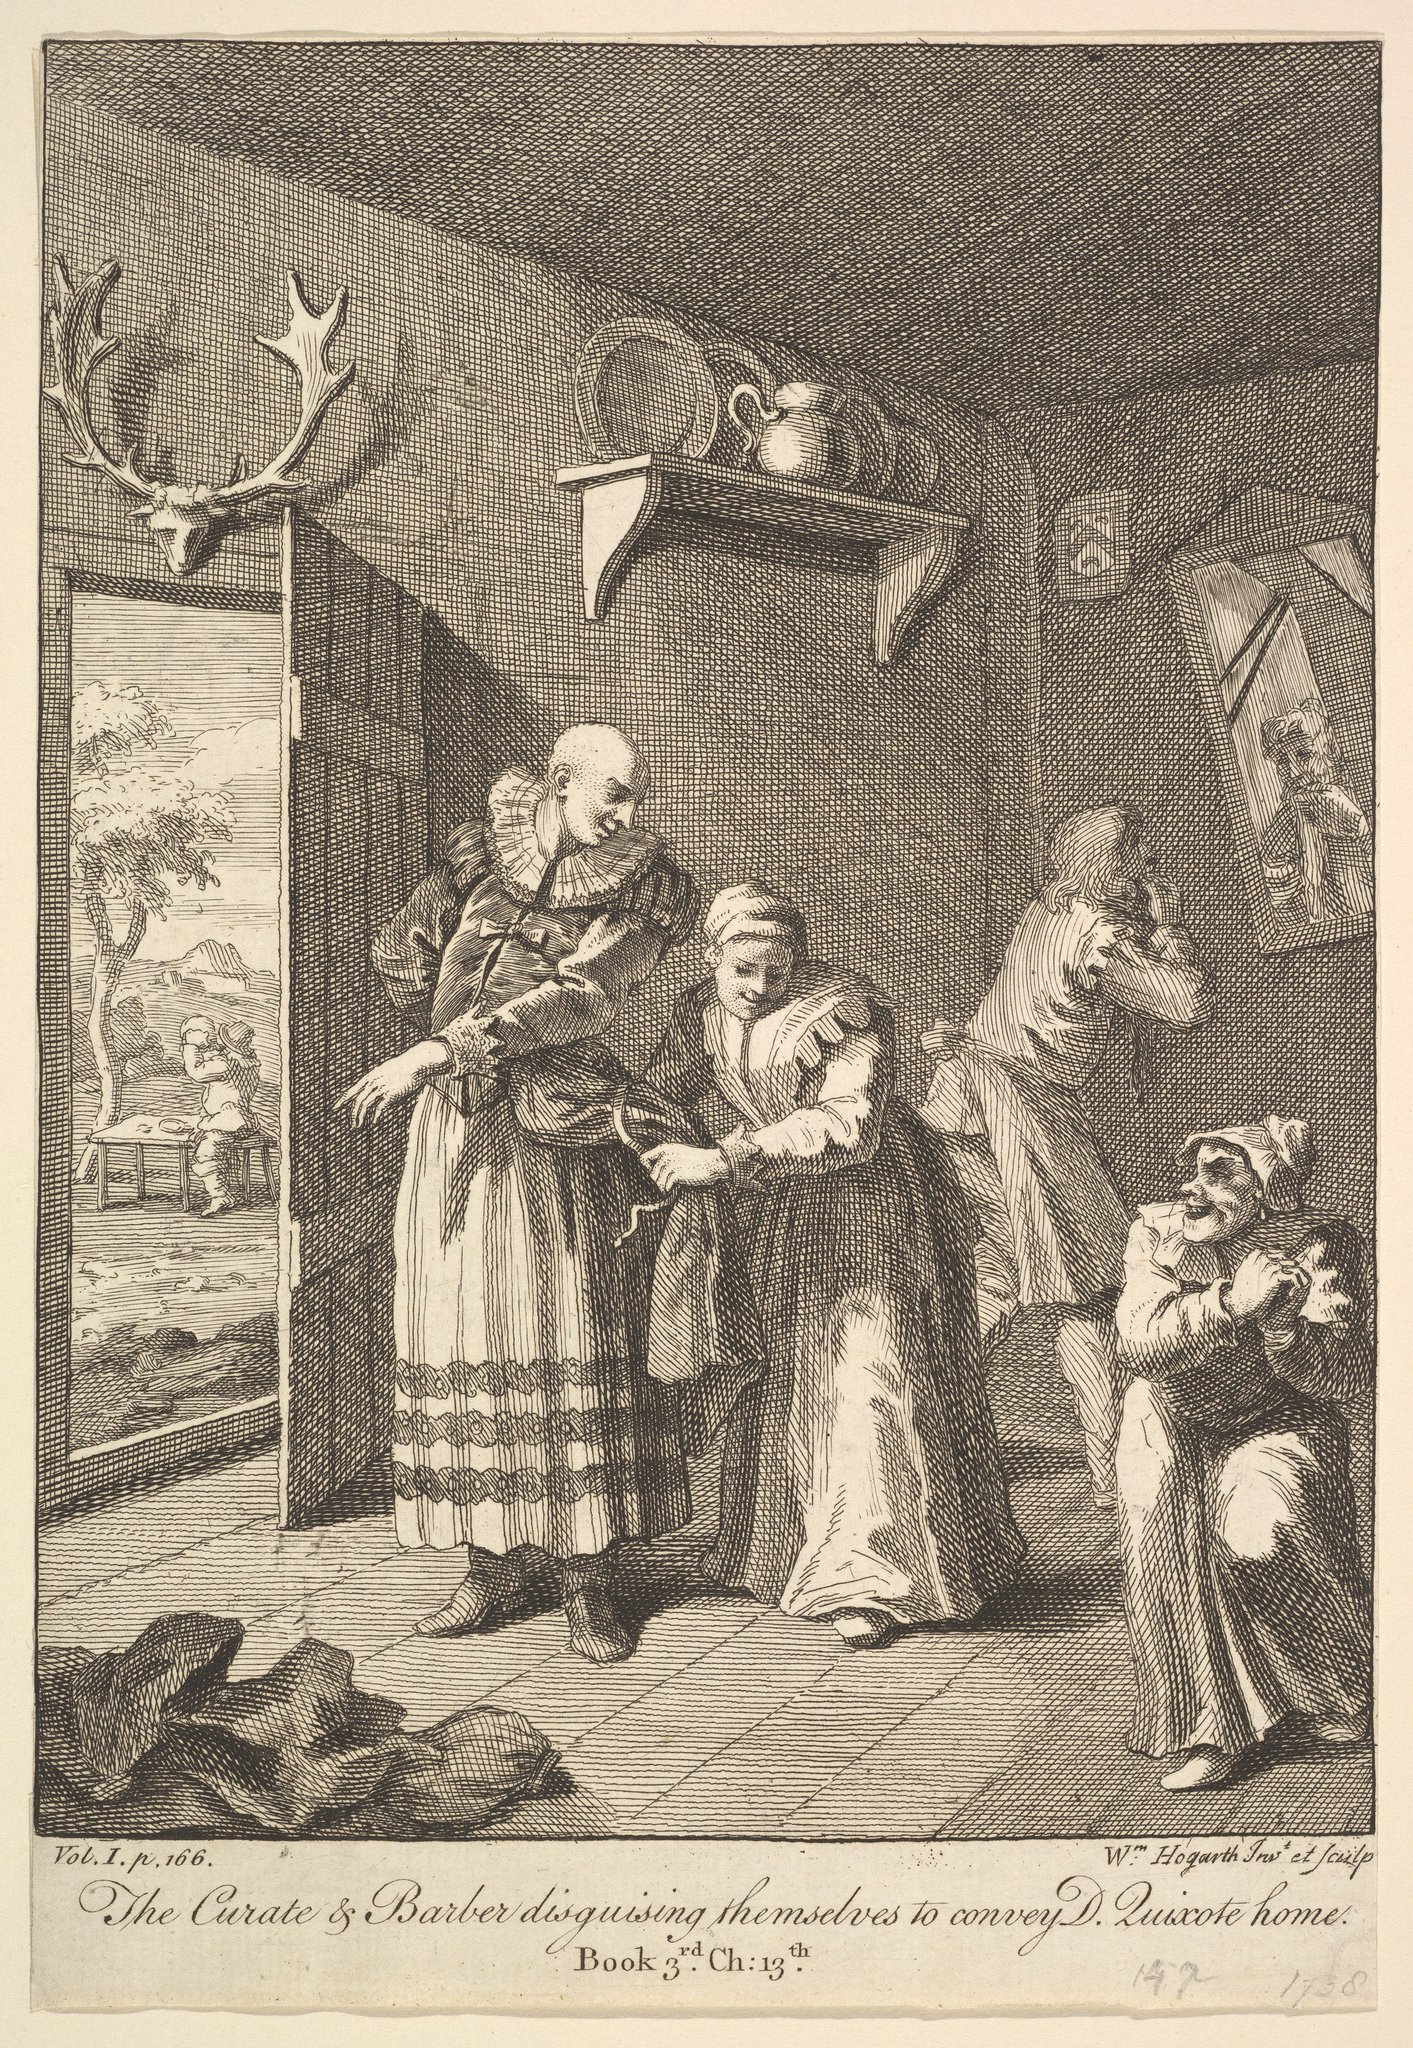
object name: print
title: The Curate and Barber Disguising Themselves to Convey Don Quixote Home (Six Illustrations for Don Quixote)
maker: william hogarth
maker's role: artist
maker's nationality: british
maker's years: 1697-1764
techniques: engraving, etching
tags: men,women,dressing,don quixote